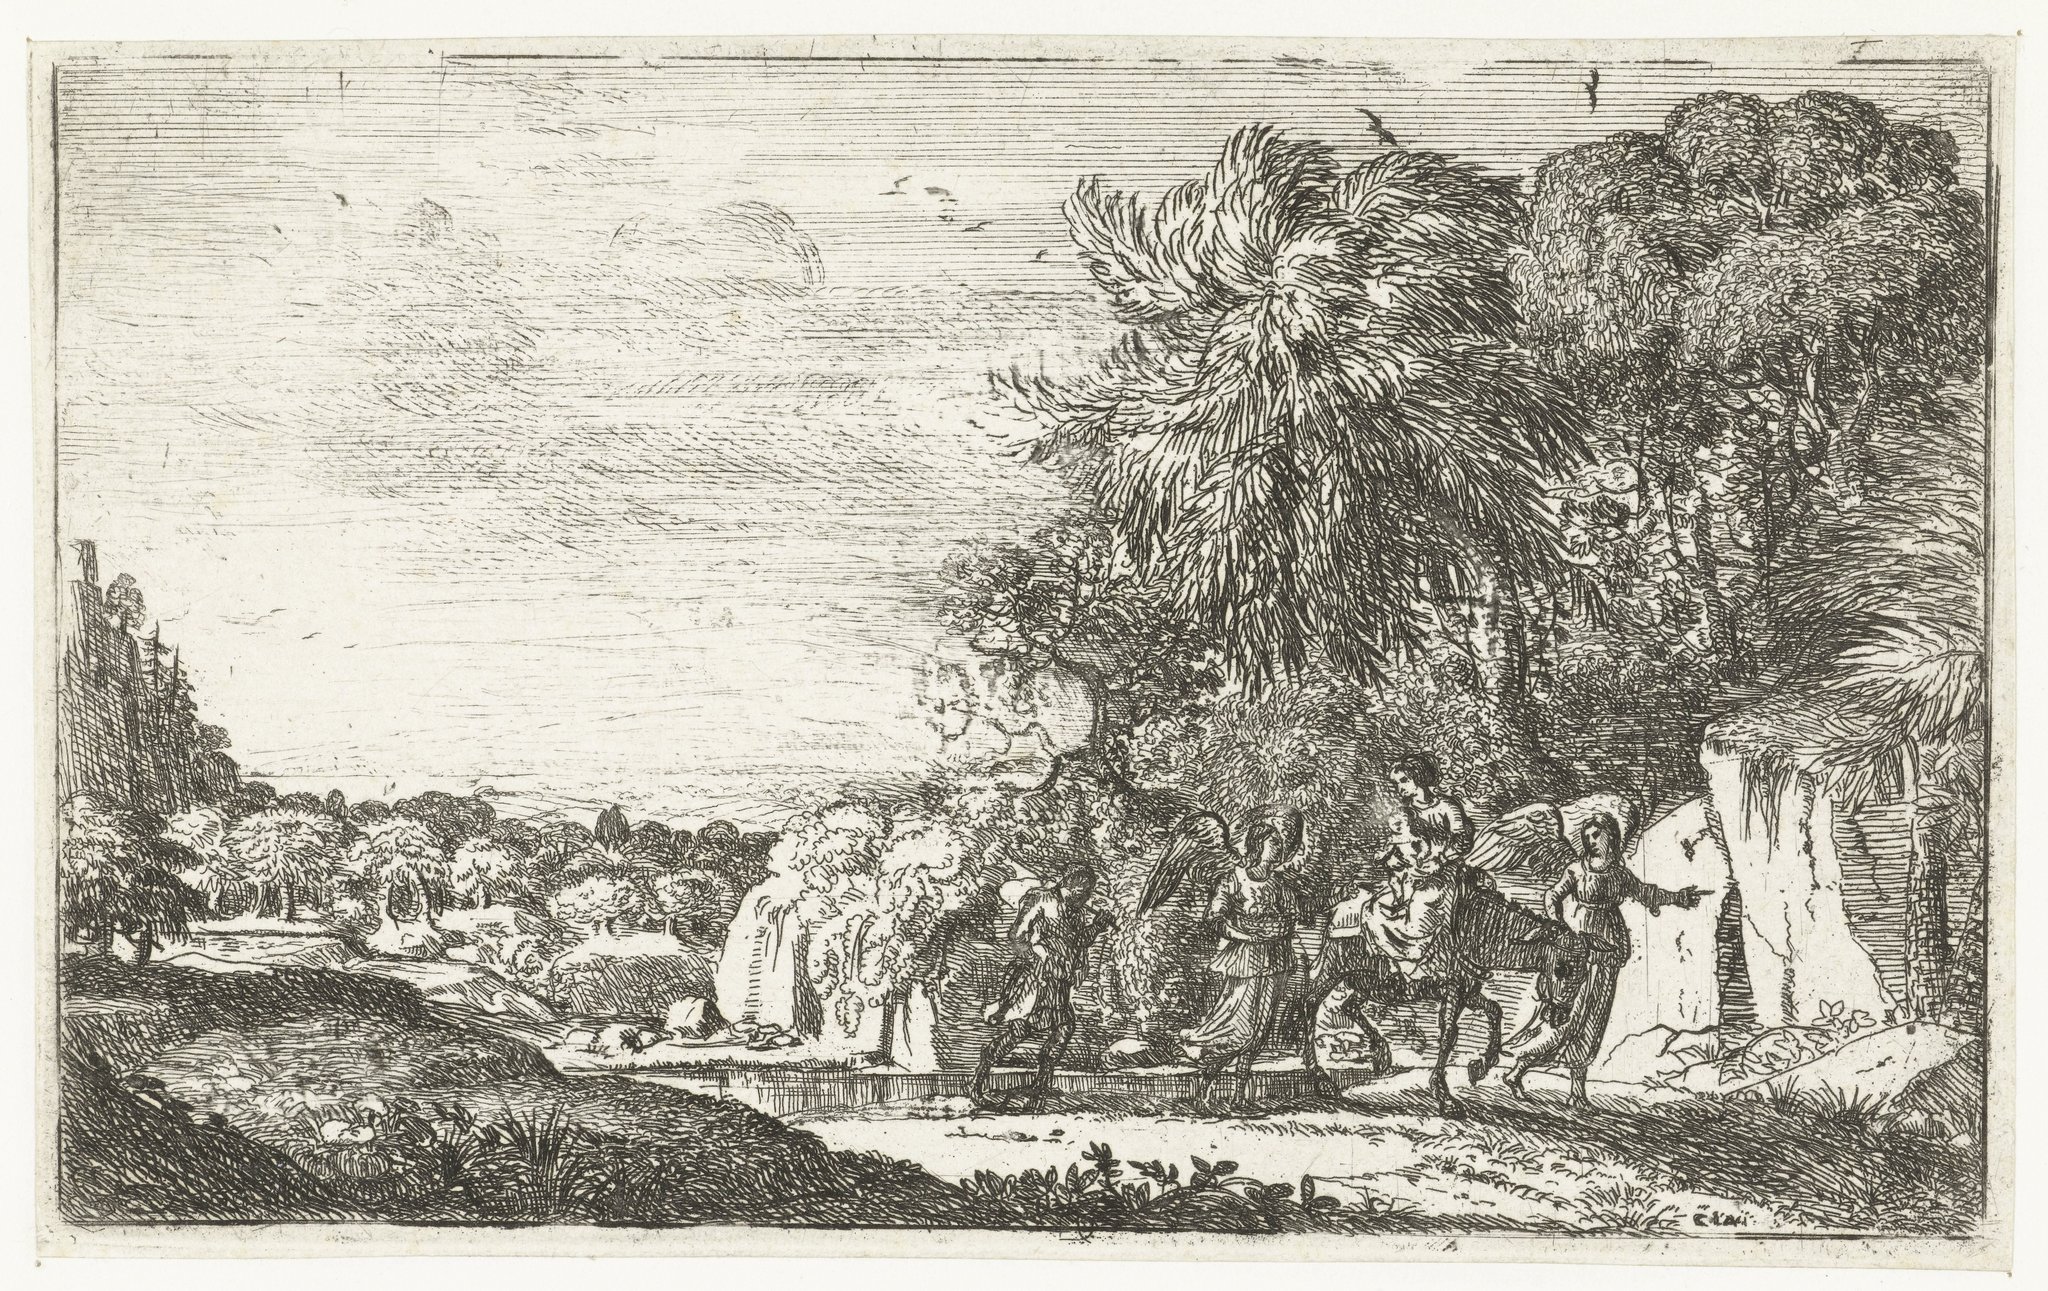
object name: print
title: La fuite en Egypte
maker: claude lorrain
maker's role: draughtsman, print maker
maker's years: 1604-1682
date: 1630-1633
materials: paper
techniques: etching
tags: the flight into egypt: mary, joseph, the child (and sometimes others) on their way; mary usually riding on an ass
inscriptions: collector's mark: Lugt 240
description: Landschap met Maria met het Christuskind op een ezel, begeleid door twee engelen, gevolgd door Jozef.